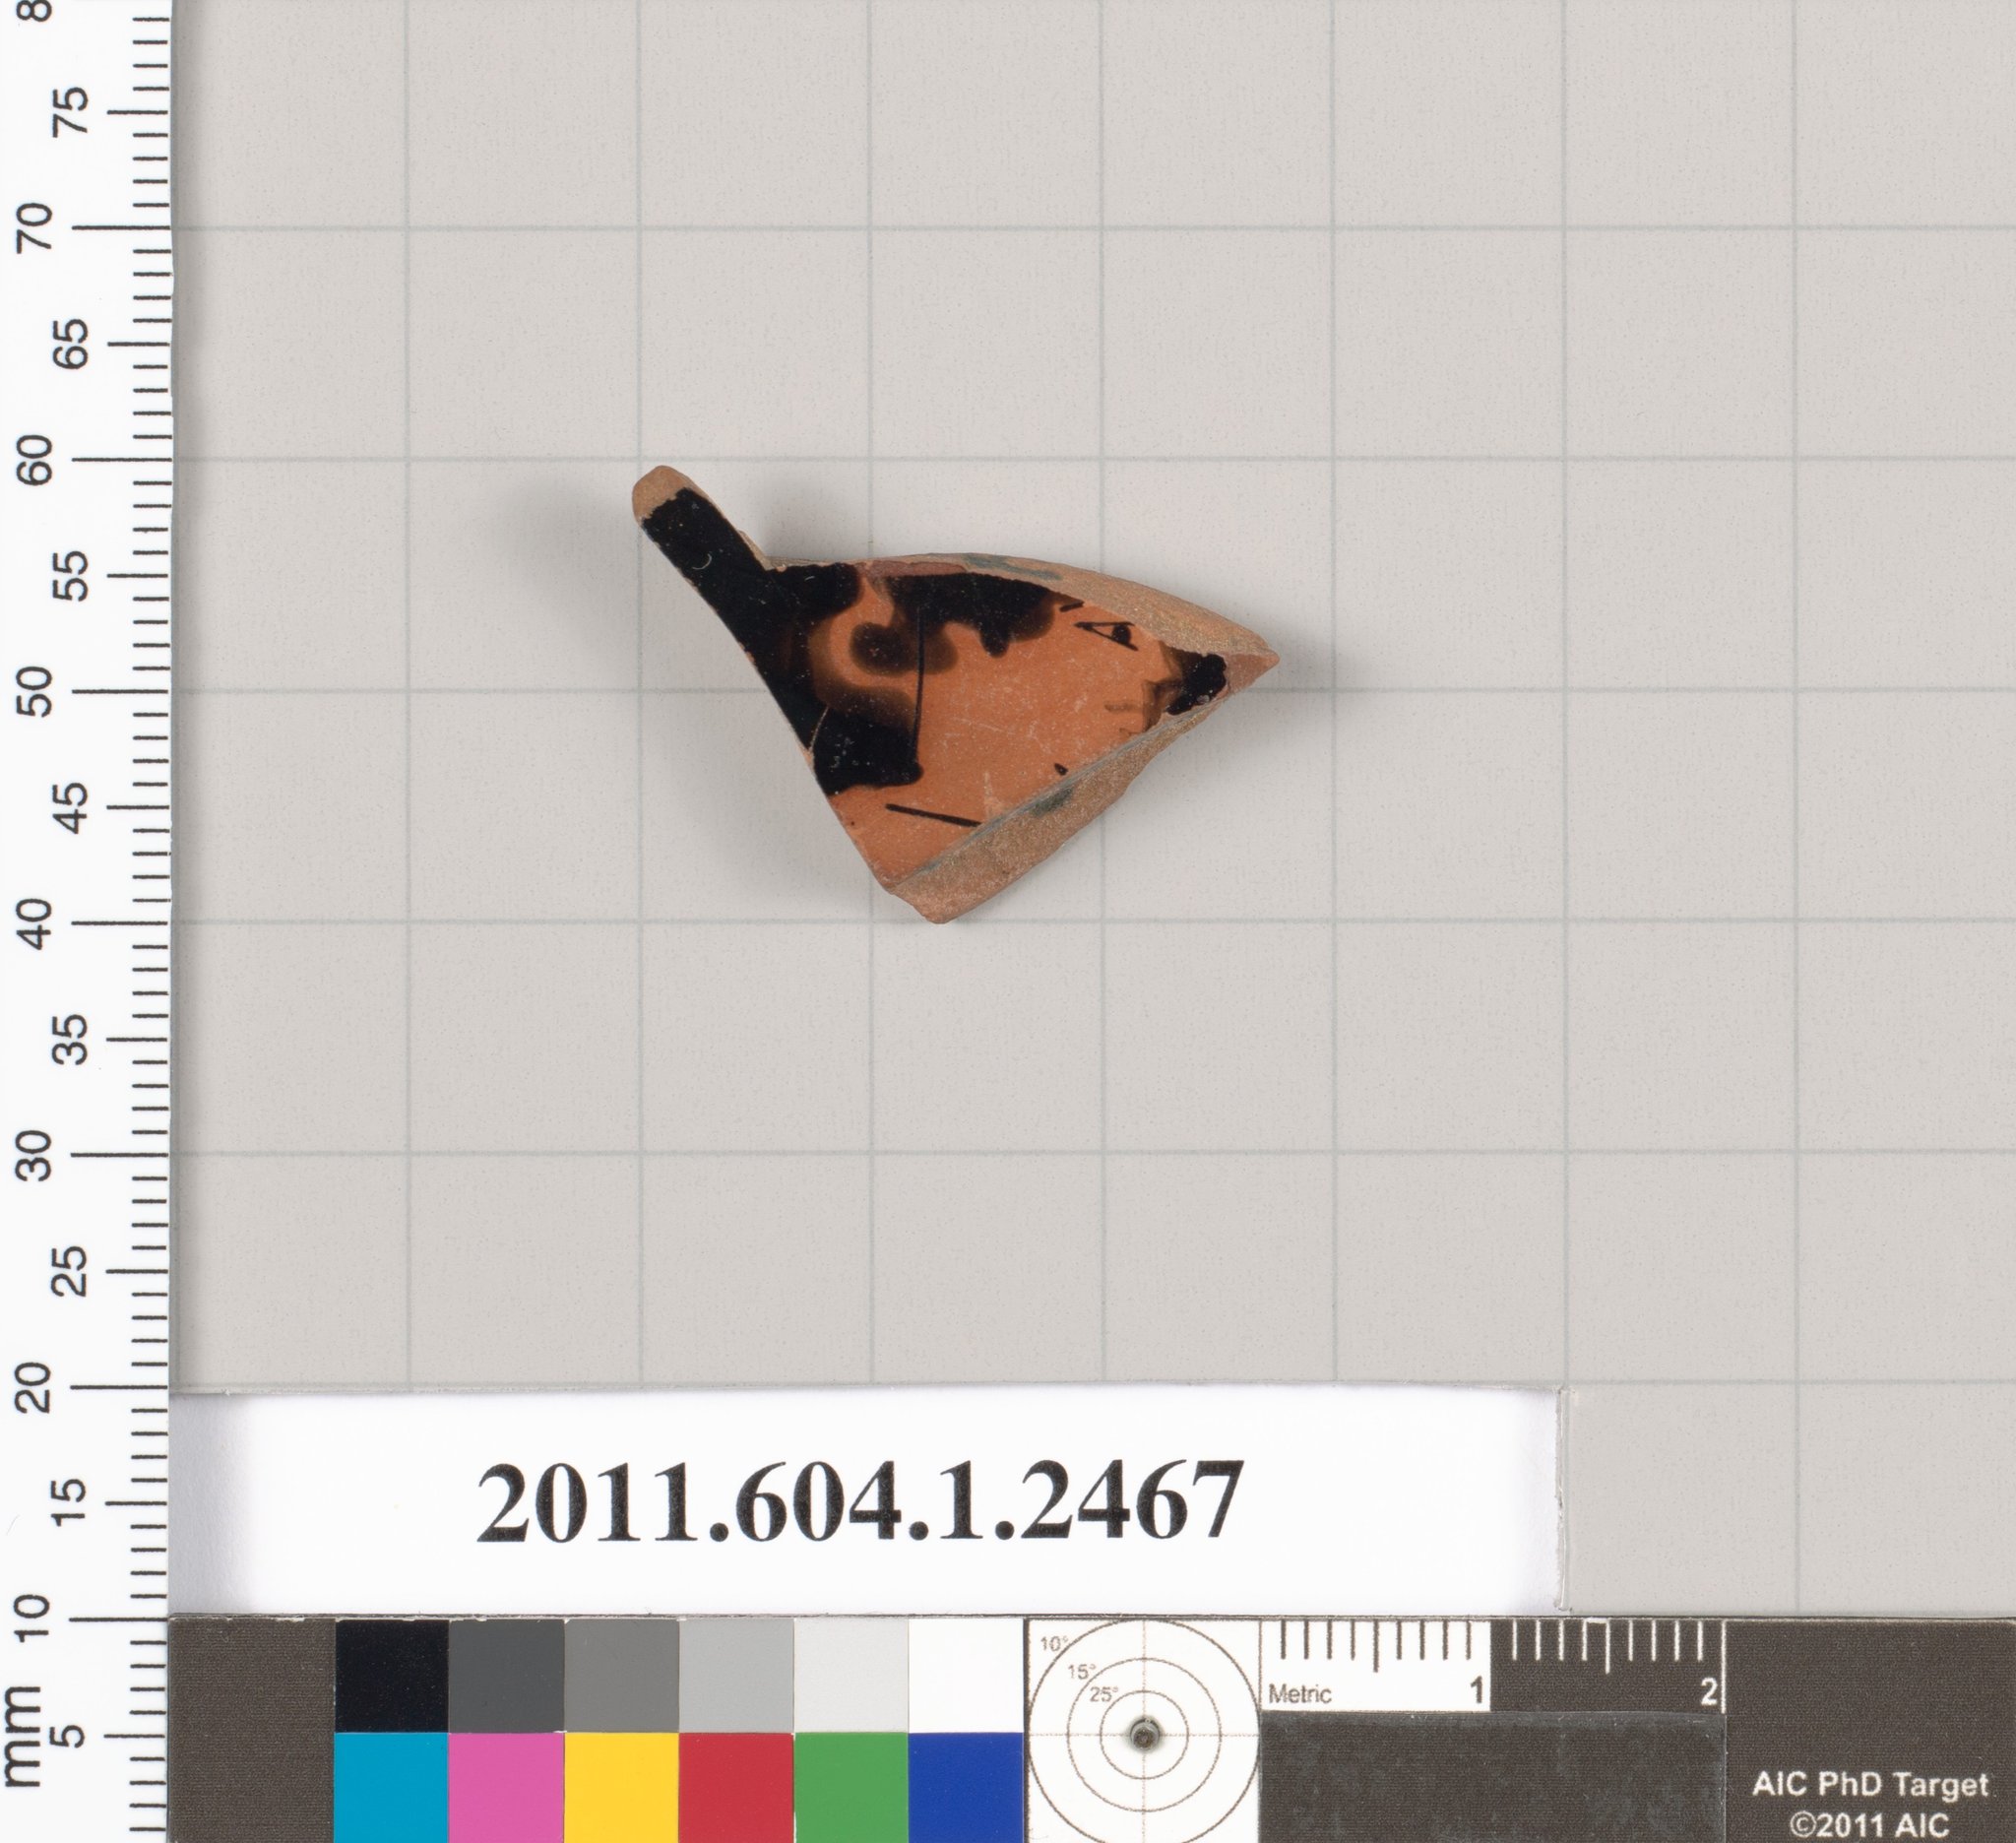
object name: kylix fragment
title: Terracotta fragment of a kylix (drinking cup)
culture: greek, attic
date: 475-451 BCE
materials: terracotta